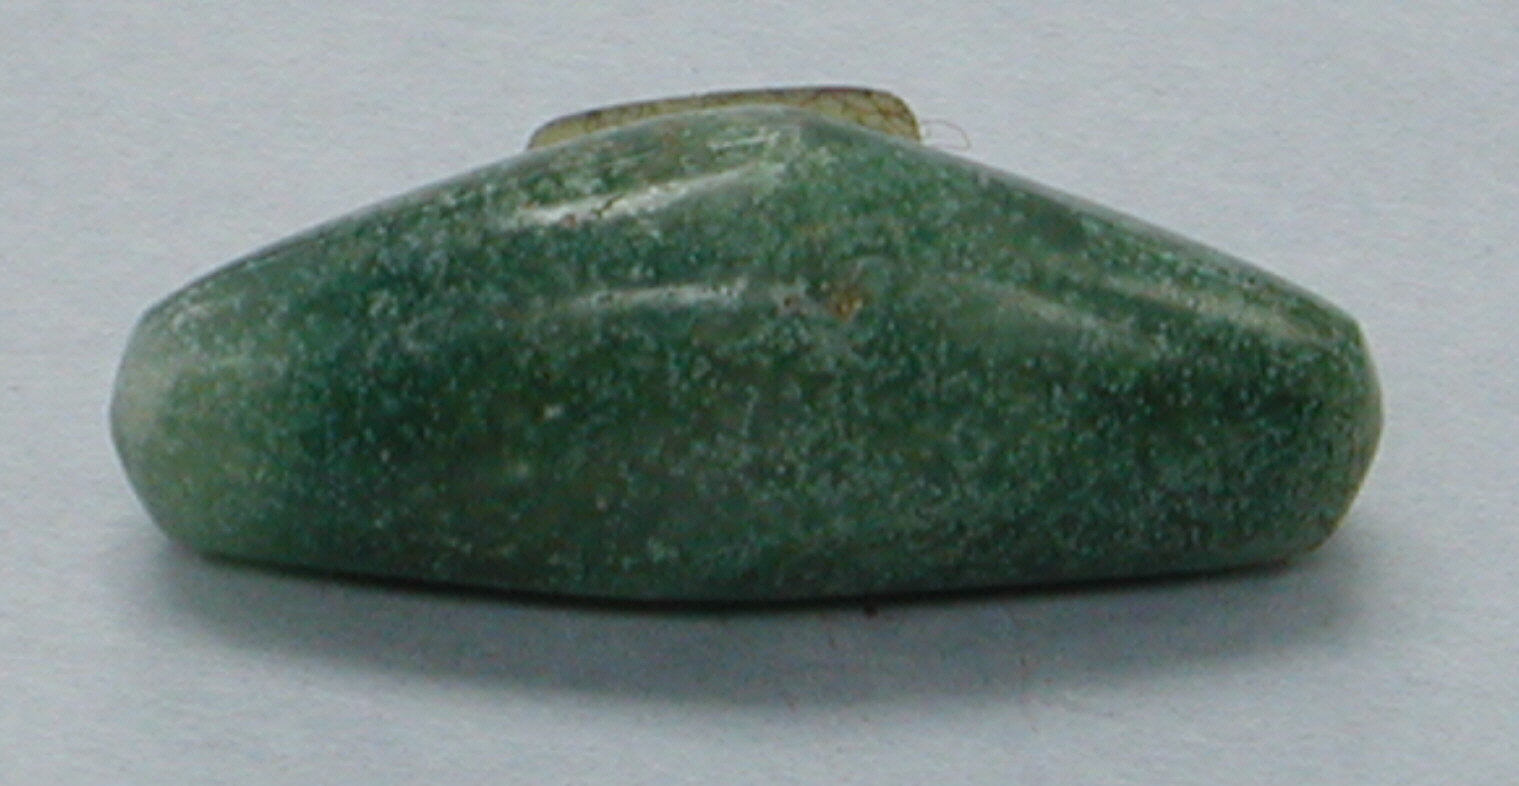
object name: ritual stone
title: Stone Pulidor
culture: mexican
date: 1501-1600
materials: stone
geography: mexico